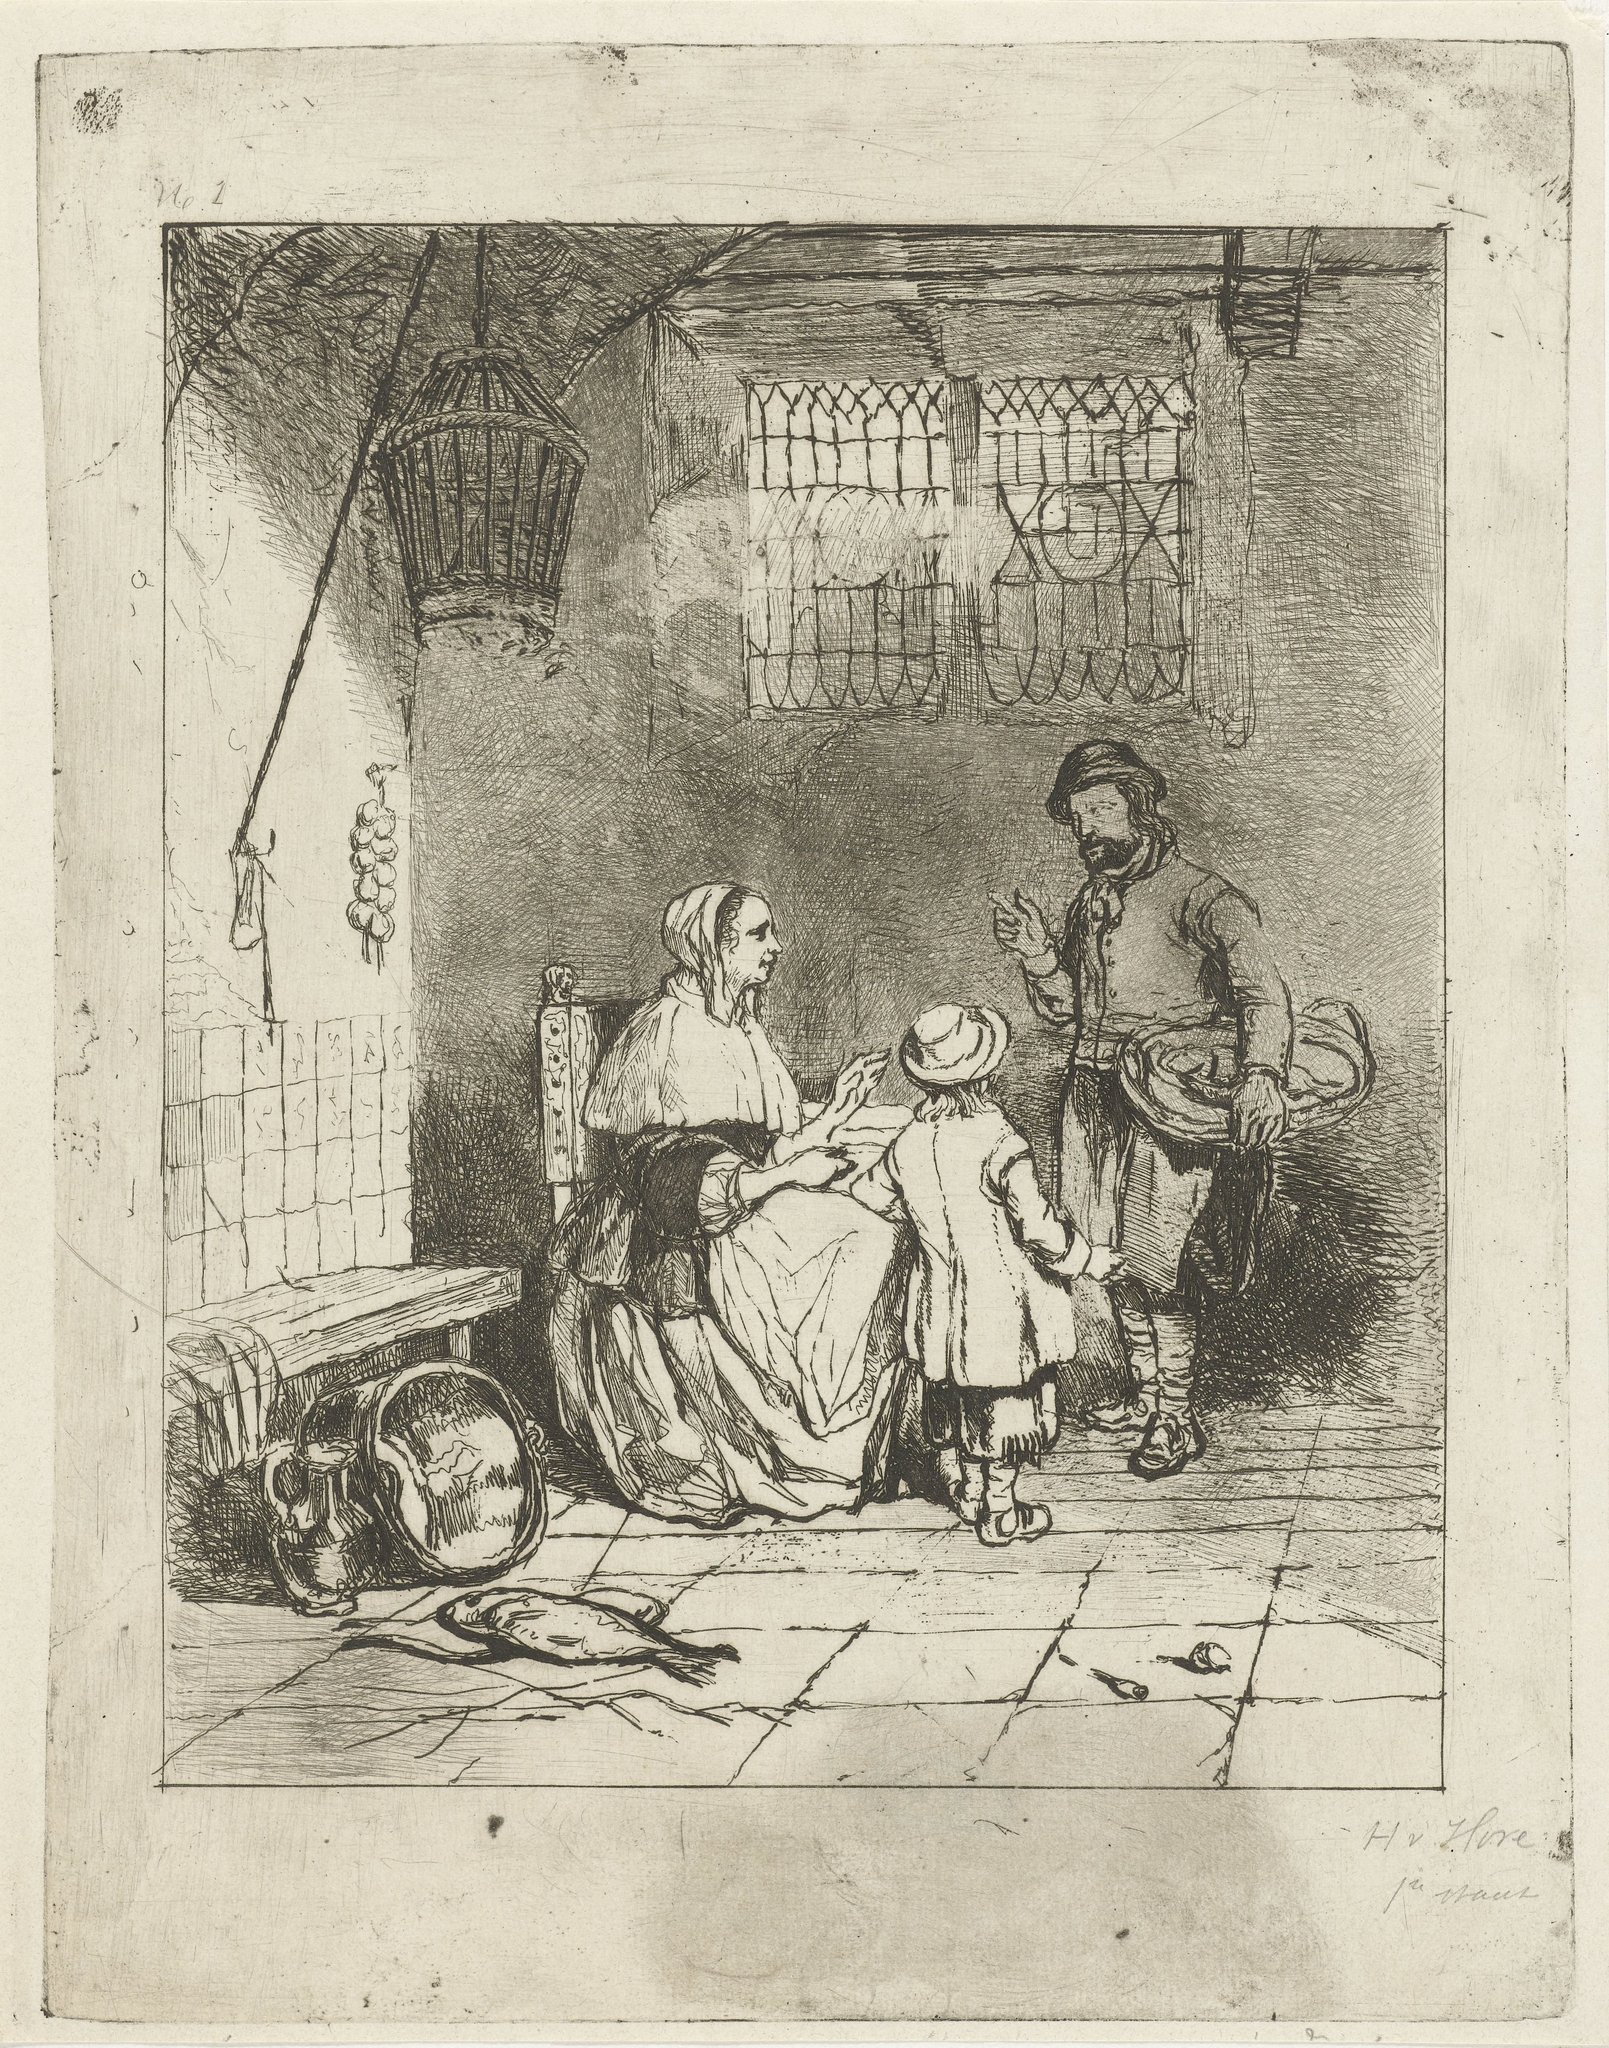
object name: print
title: Drie figuren in een keukeninterieur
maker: huib van hove bz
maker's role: painter, print maker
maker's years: 1814-1867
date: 1824-1864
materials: paper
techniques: etching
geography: low countries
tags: kitchen-interior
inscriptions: collector's mark: Lugt 2228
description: In een keukeninterieur staat rechts een man met een mand onder de arm. In het midden staat een jongen op de rug gezien. Links een zittende vrouw. Links op de voorgrond een kan, een ketel en een vis.